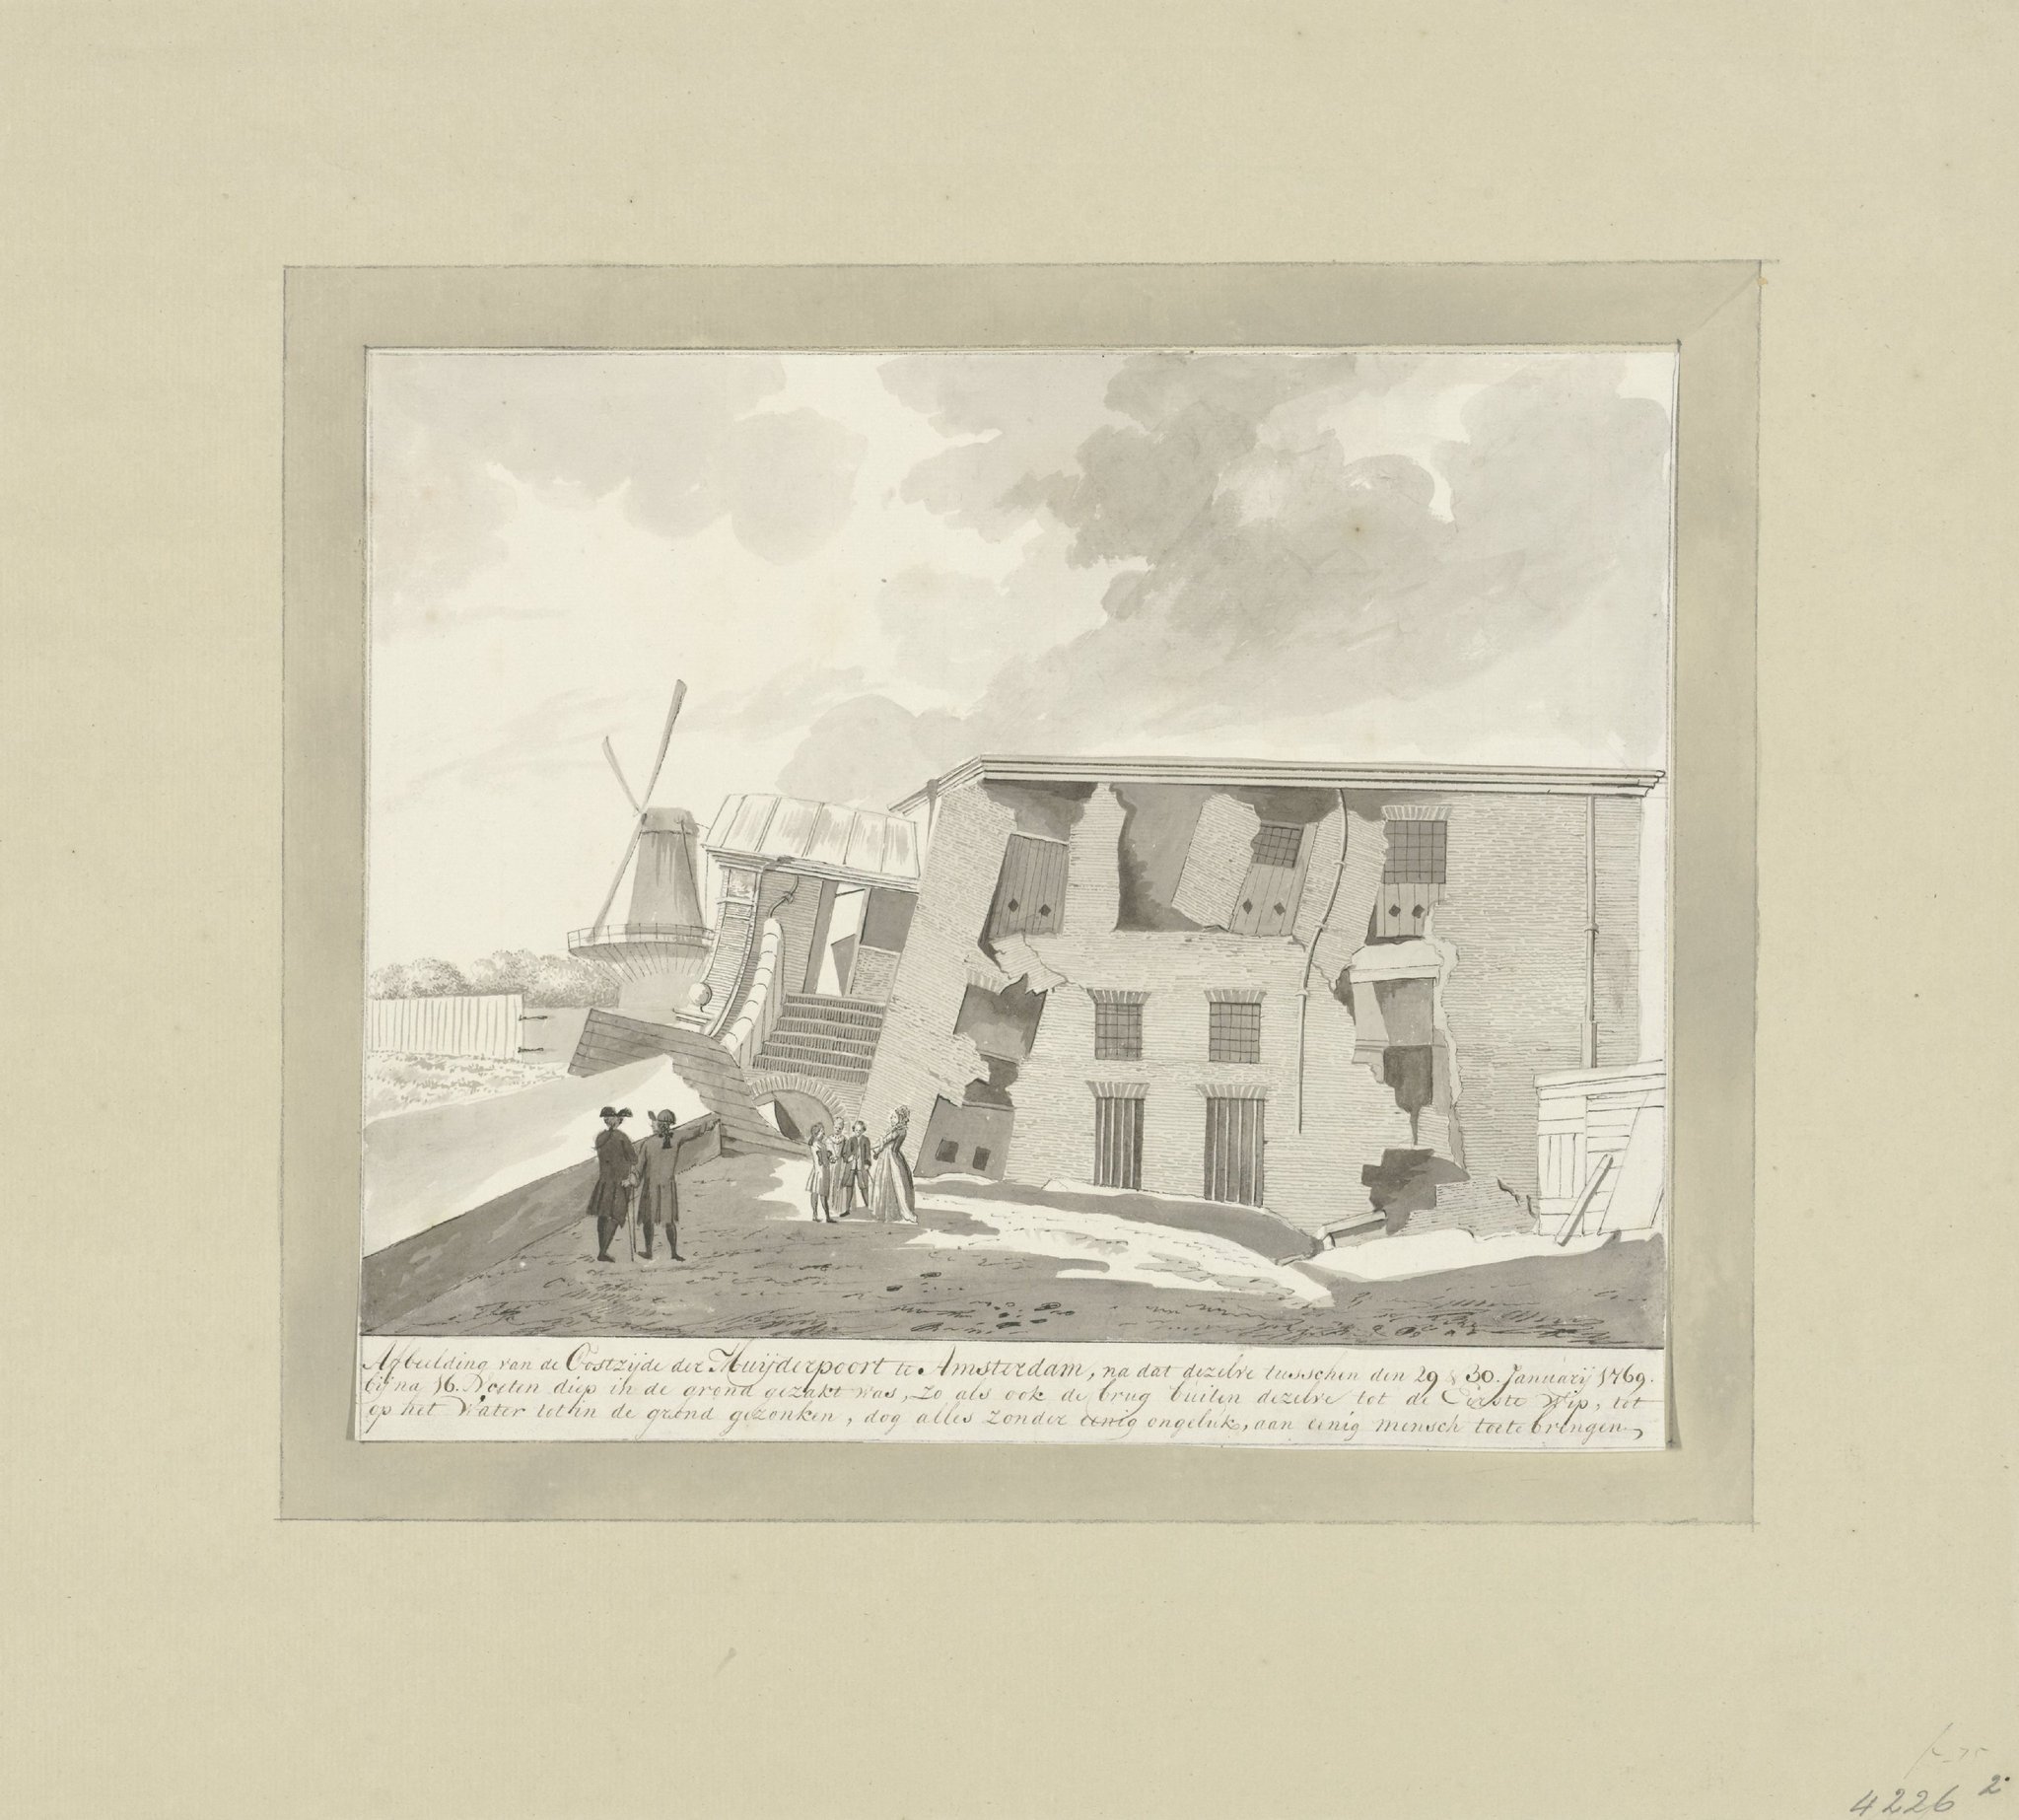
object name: drawing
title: Afbeelding van de oostzijde van de ingestorte Muiderpoort te Amsterdam, 1769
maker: hendrik tavenier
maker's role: draughtsman, print maker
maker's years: 1734-1807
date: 1784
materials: paper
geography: amsterdam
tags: city-gate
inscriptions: signature and date: ‘de ingesakte Muyder poort te Amsterdam / 1784 / H: Tavenier f:’, collector's mark: Lugt 2228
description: De oostzijde van de ruïne van de in de nacht van 29 op 30 januari 1769 ingestorte Muiderpoort te Amsterdam. Met enkele toeschouwers bij de ruïne, de situatie toont het al deels gesloopte gebouw, waarschijnlijk begin februari 1769.